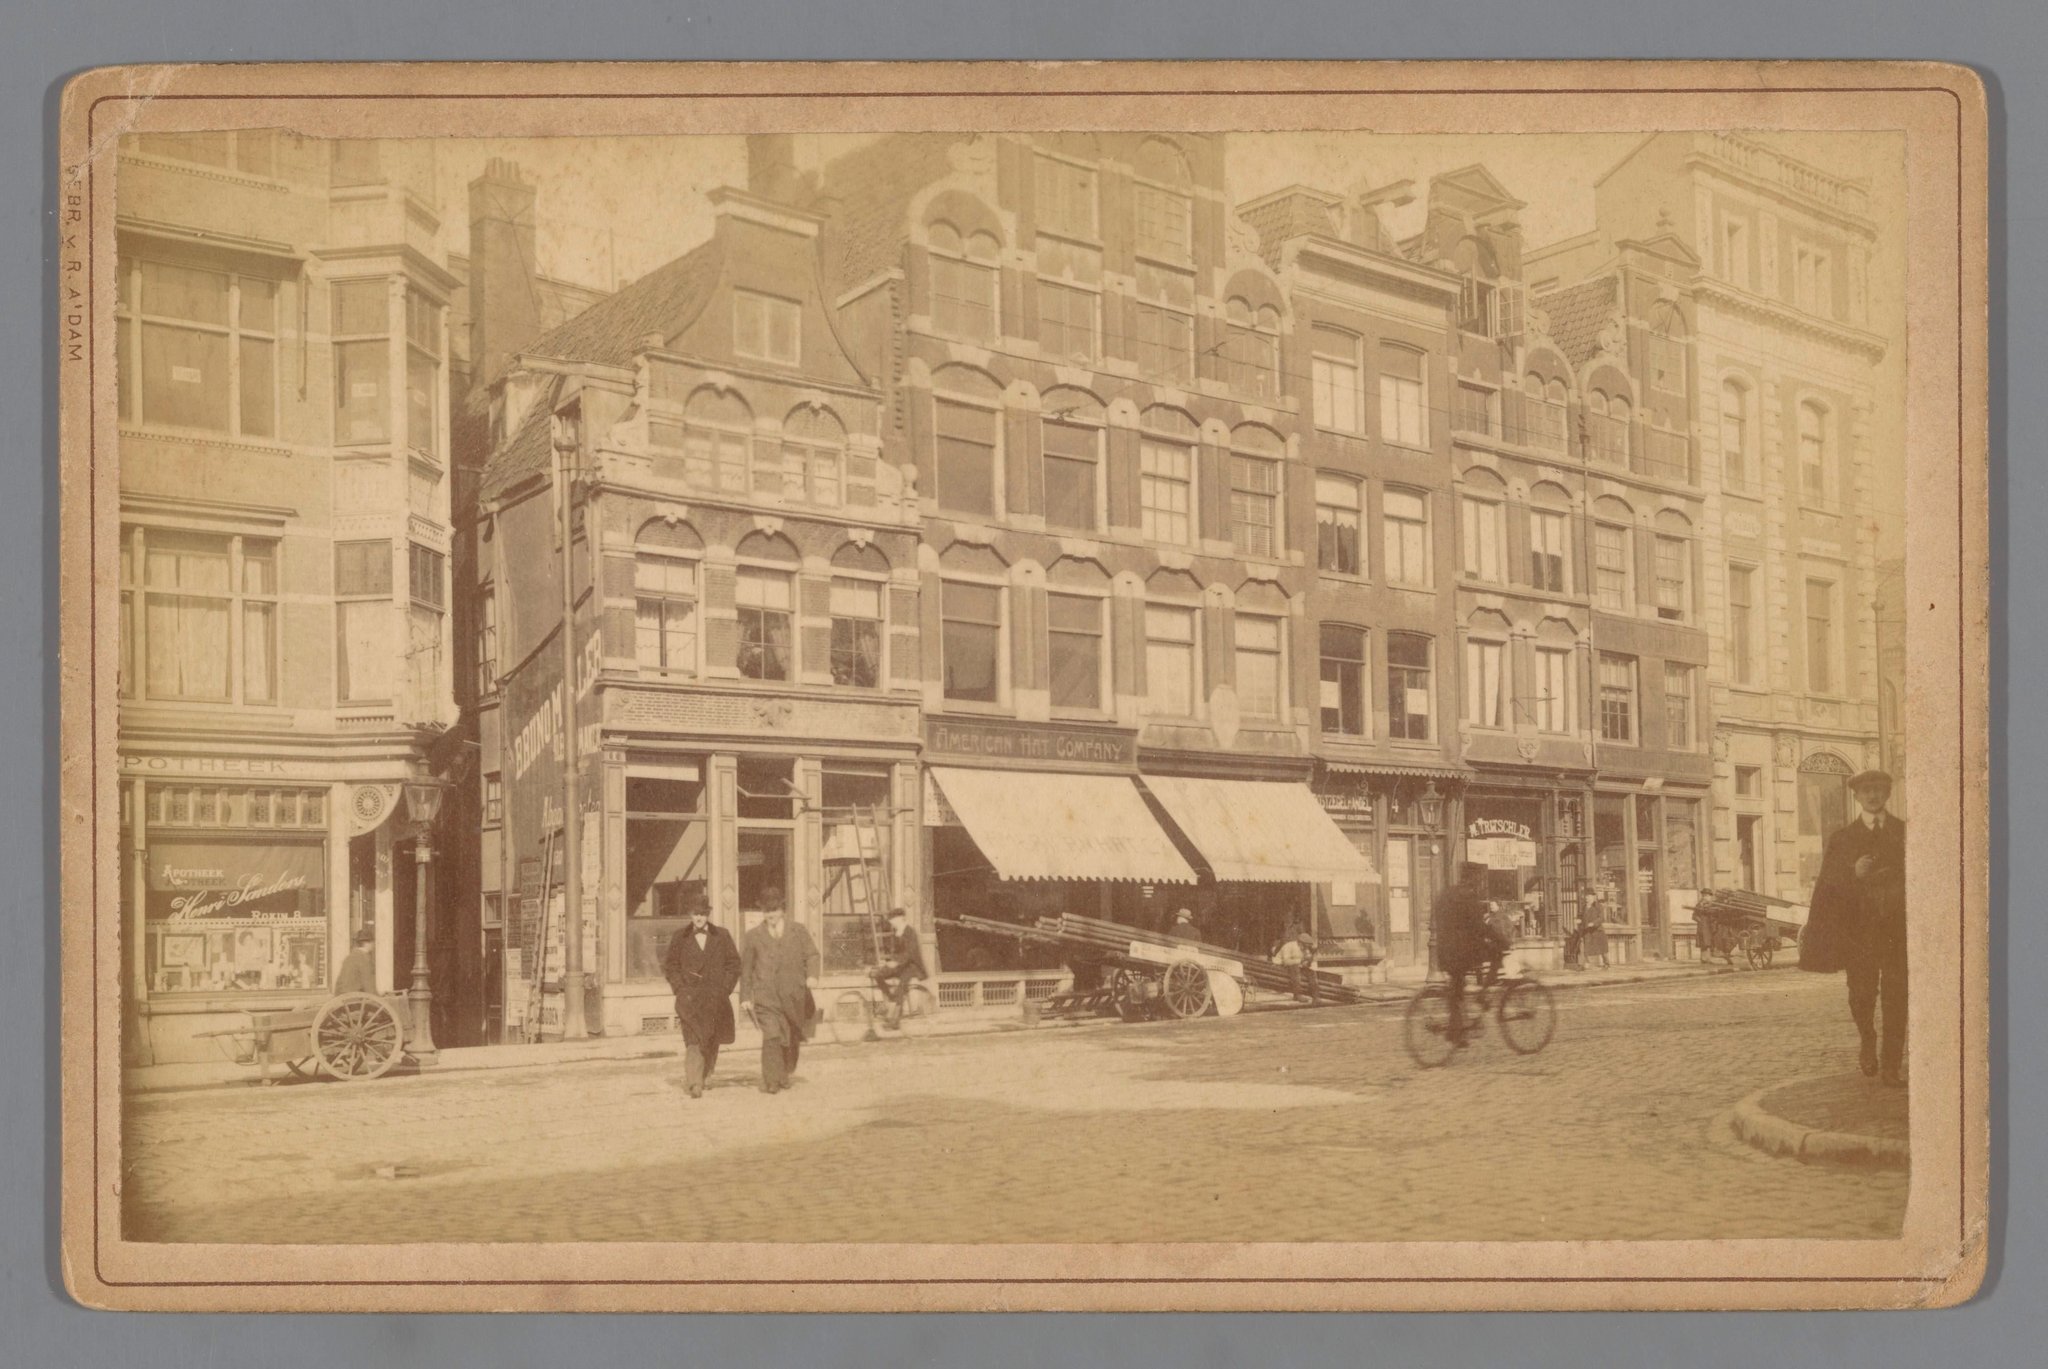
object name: photograph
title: Gezicht op het Rokin in Amsterdam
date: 1902-1907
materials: cardboard, photographic support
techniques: albumen print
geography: amsterdam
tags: street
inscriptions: annotation: ‘Rokin’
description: Gezicht op onder ander de panden van Apotheek Henri Sanders (Rokin 8), de American Hat Company (Rokin 6) en uurwerkmaker M. Tritschler (Rokin 4).